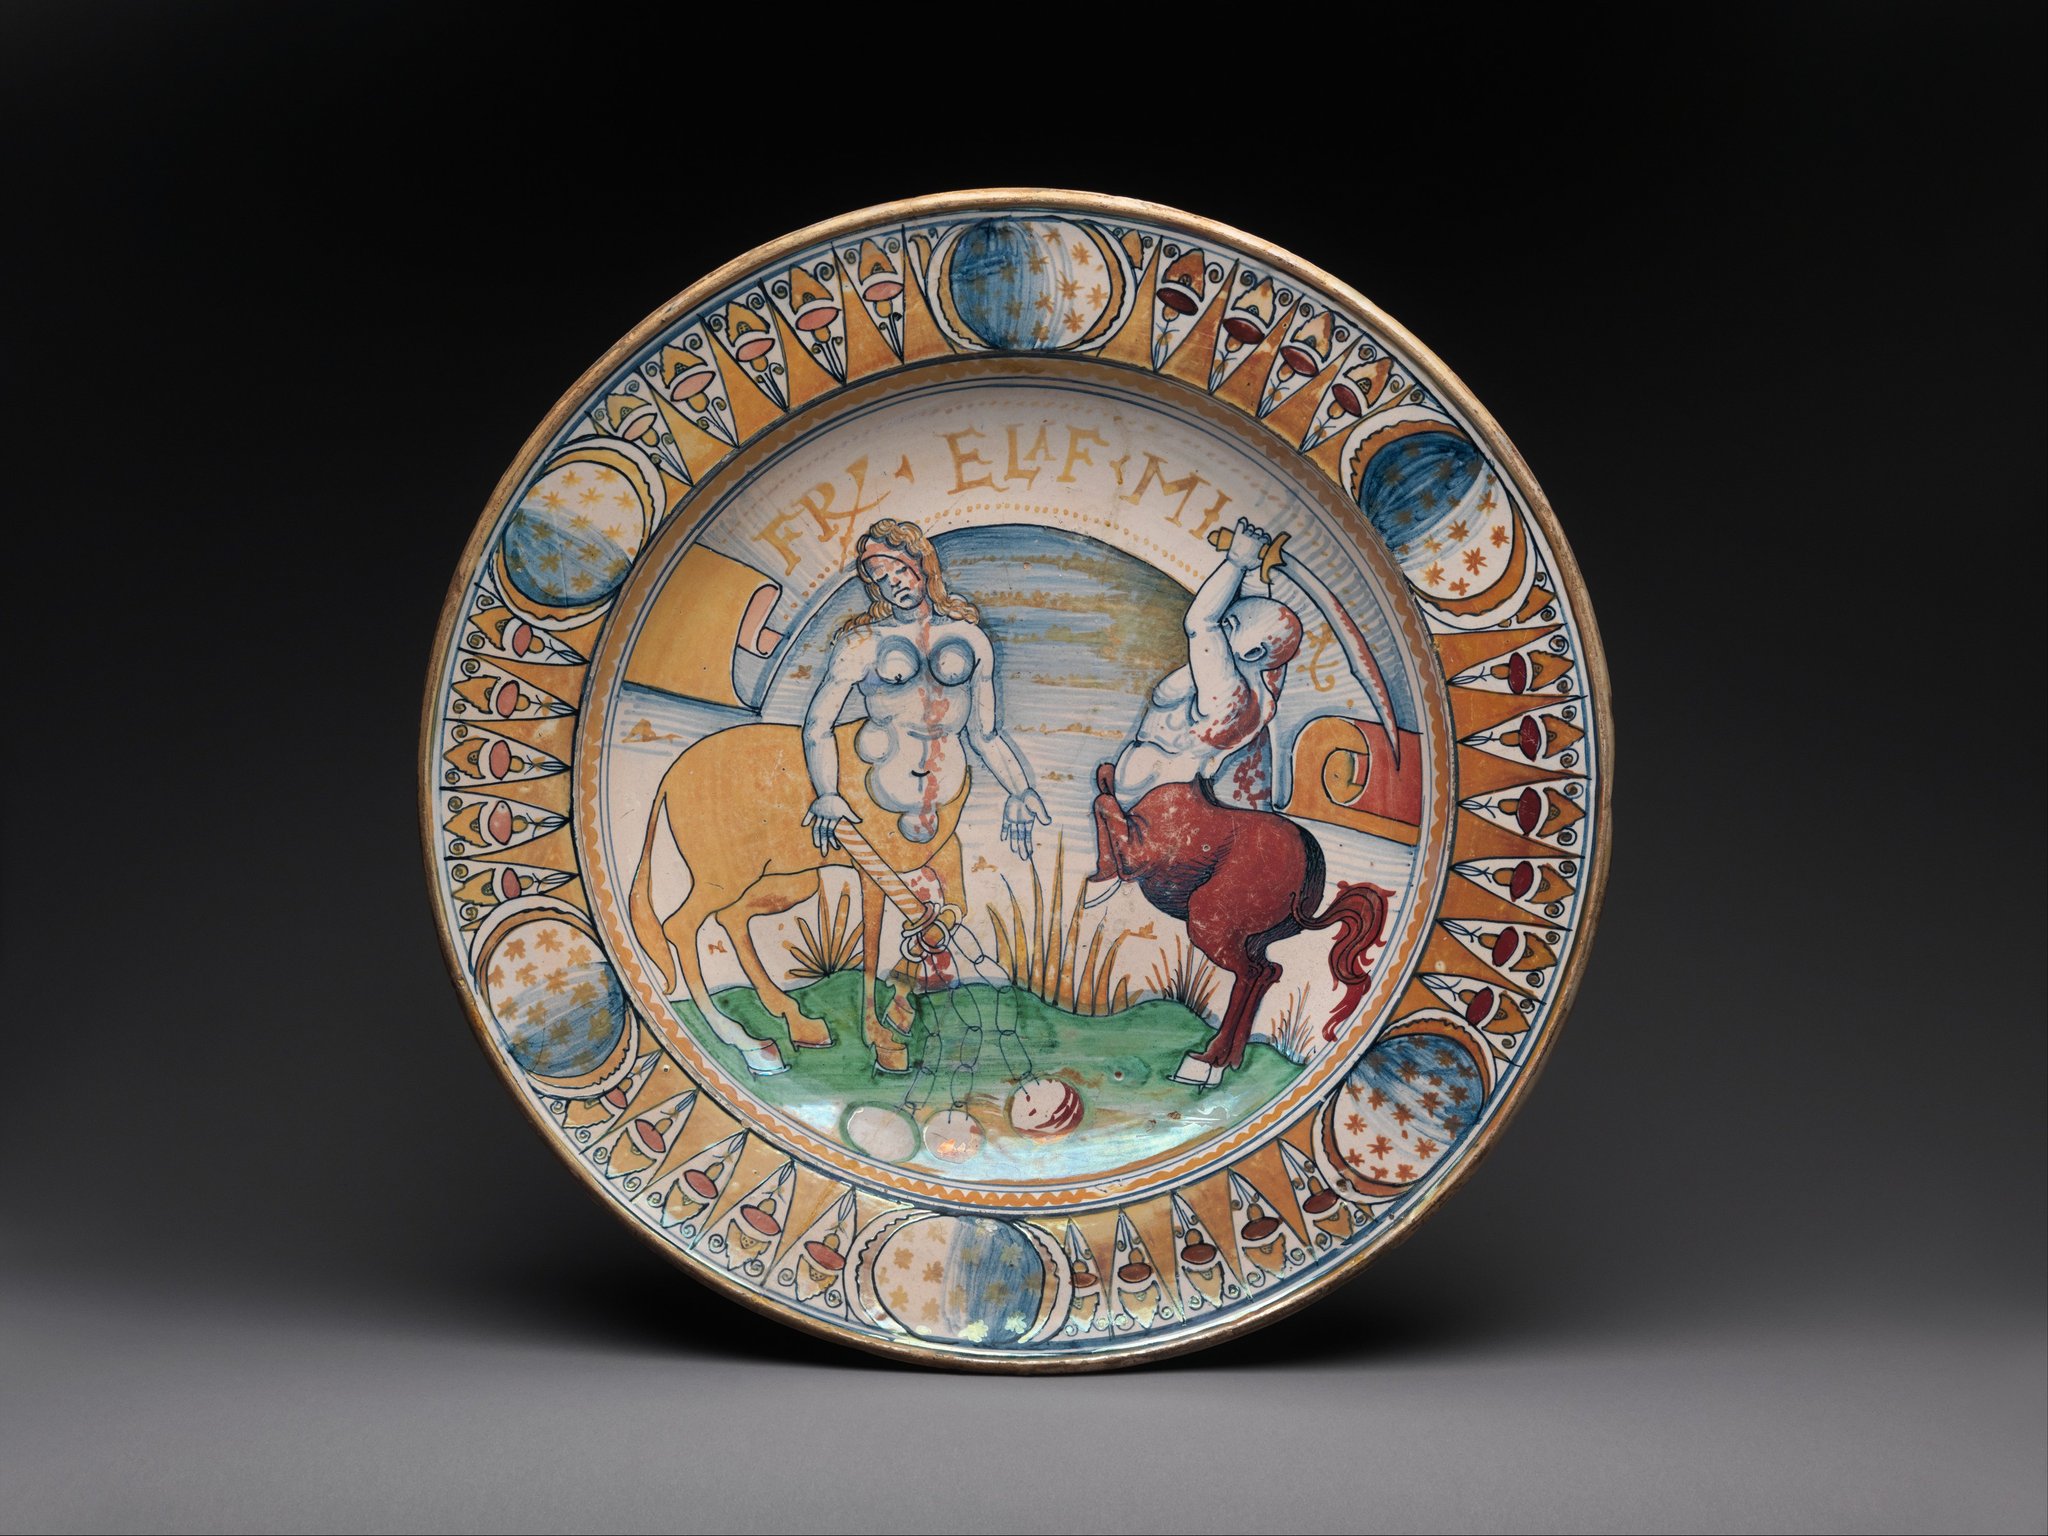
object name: dish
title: Dish with centaur and centauress battling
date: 1500-1510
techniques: maiolica, glazing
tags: battles,centaurs